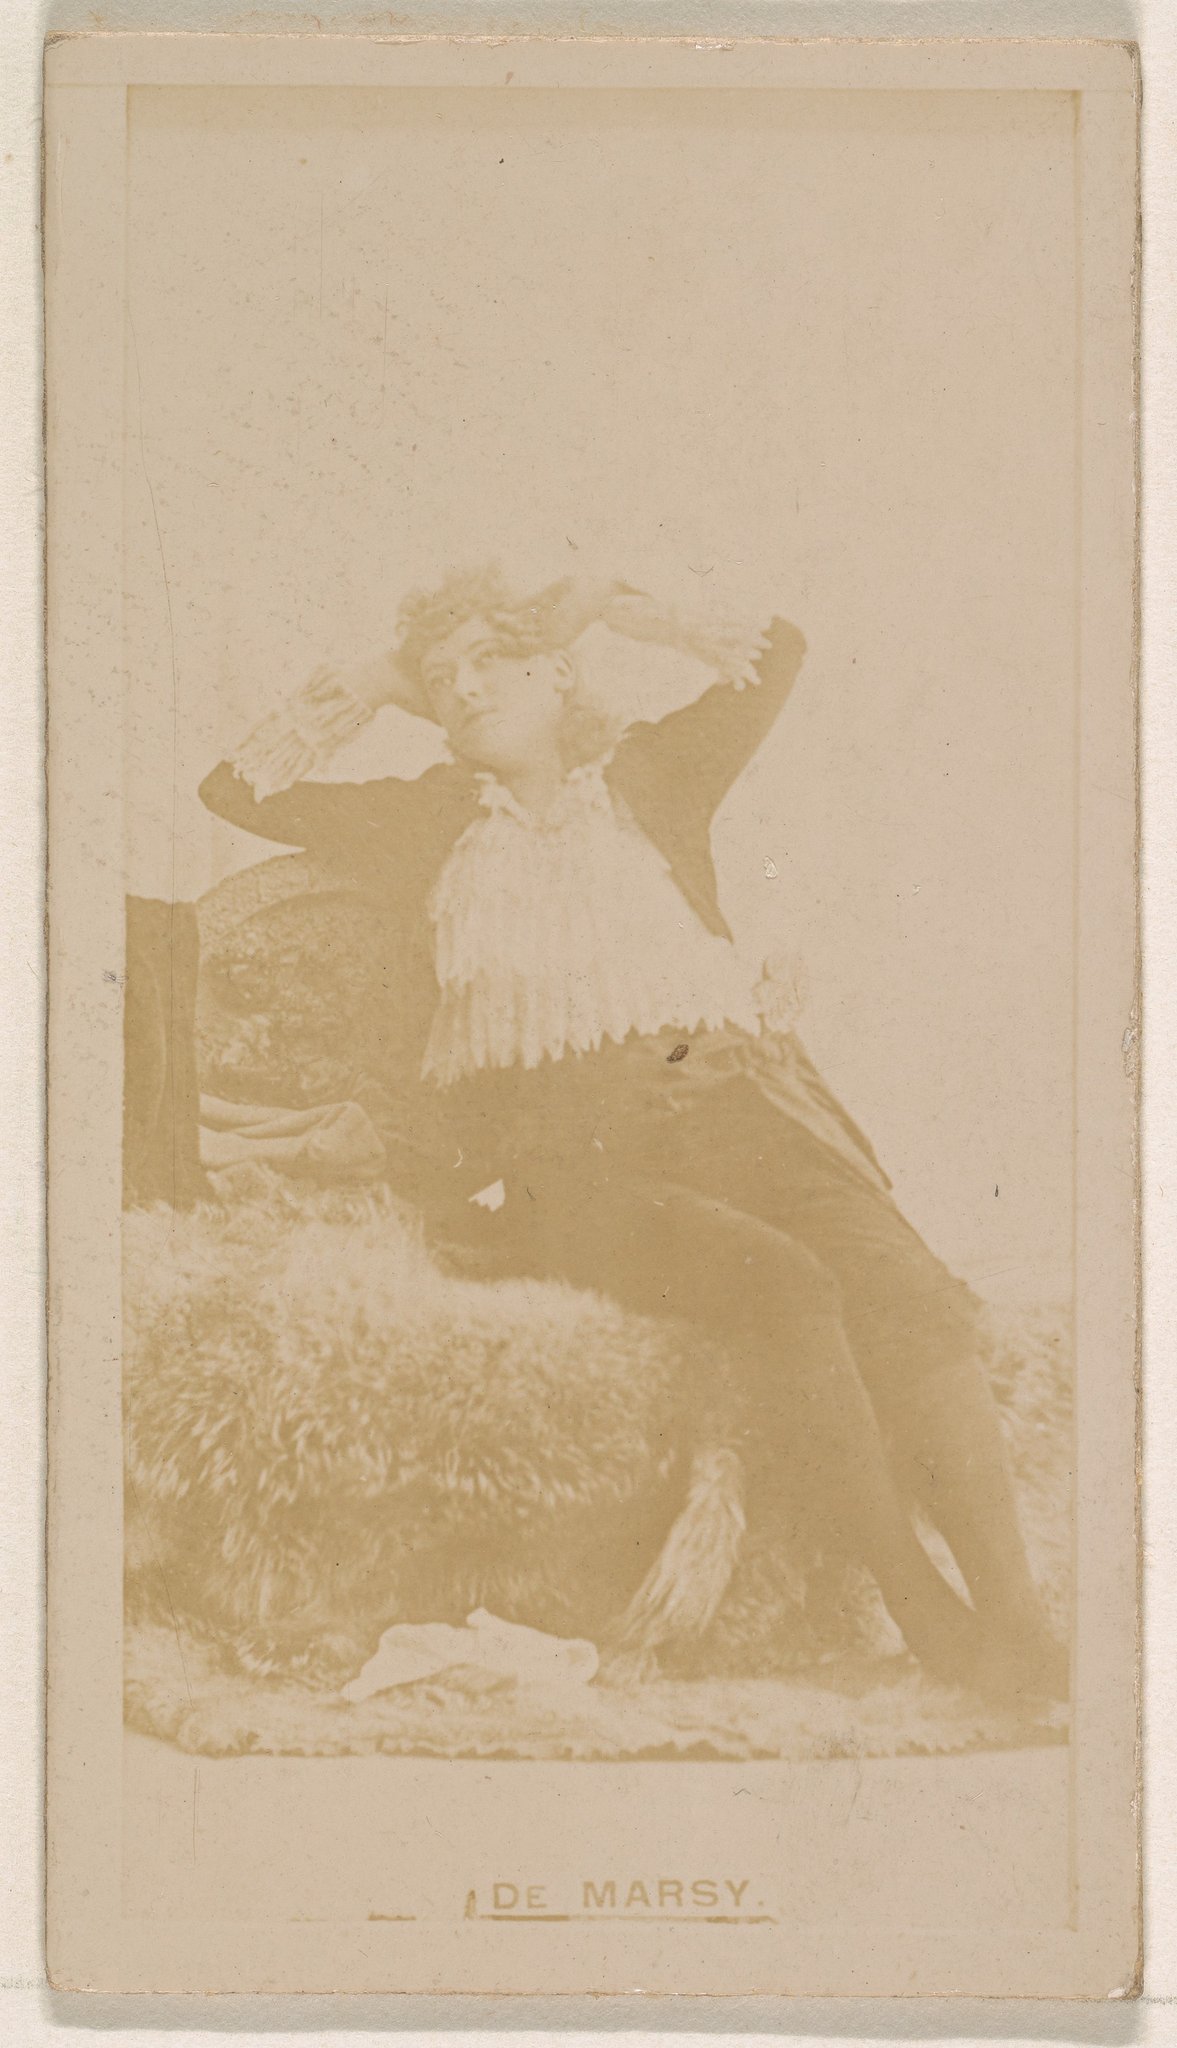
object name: photograph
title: Miss de Marsy, from the Actresses series (N245) issued by Kinney Brothers to promote Sweet Caporal Cigarettes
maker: kinney brothers tobacco company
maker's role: publisher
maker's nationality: american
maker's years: 1869-2011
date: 1890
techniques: albumen silver print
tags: portraits,women,actresses